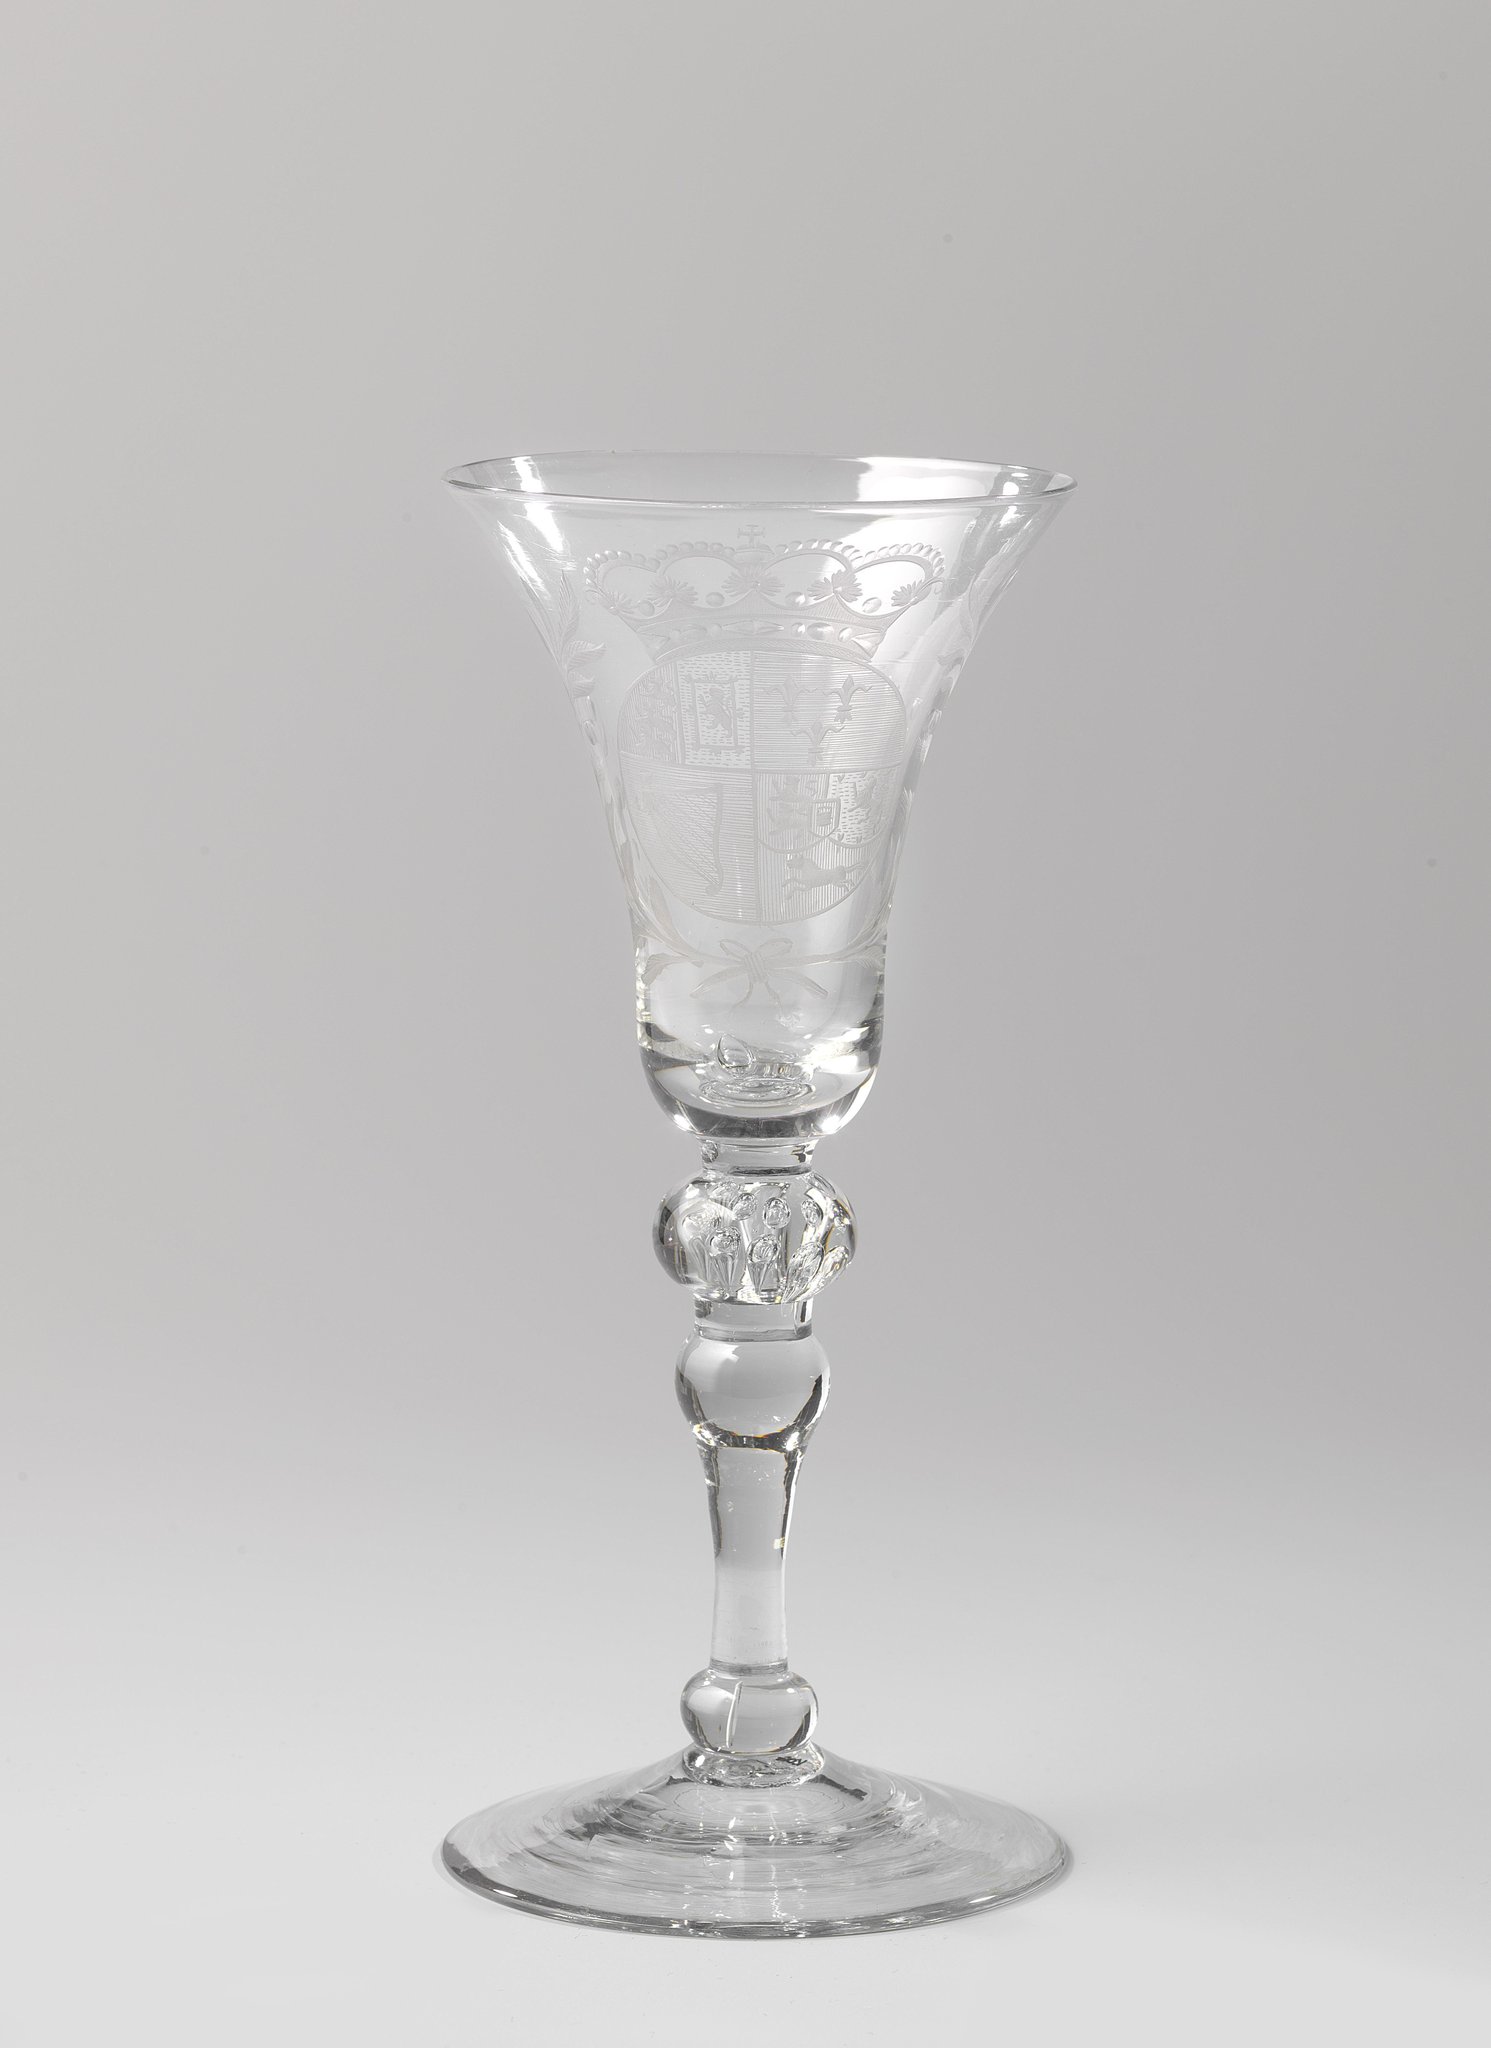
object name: goblet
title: Bokaal met alliantiewapen van Anna van Hannover en Willem IV van Oranje-Nassau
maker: Anonymous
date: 1735-1750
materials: glass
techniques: glassblowing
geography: northern netherlands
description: Gewelfde voet met omgeslagen rand. Massieve balusterstam met knop en een luchtbel. Op de conische kelk de alliantiewapens van Anna van Hannover (1709-1759) en stadhouder Willem IV van Oranje-Nassau (1711-1751).